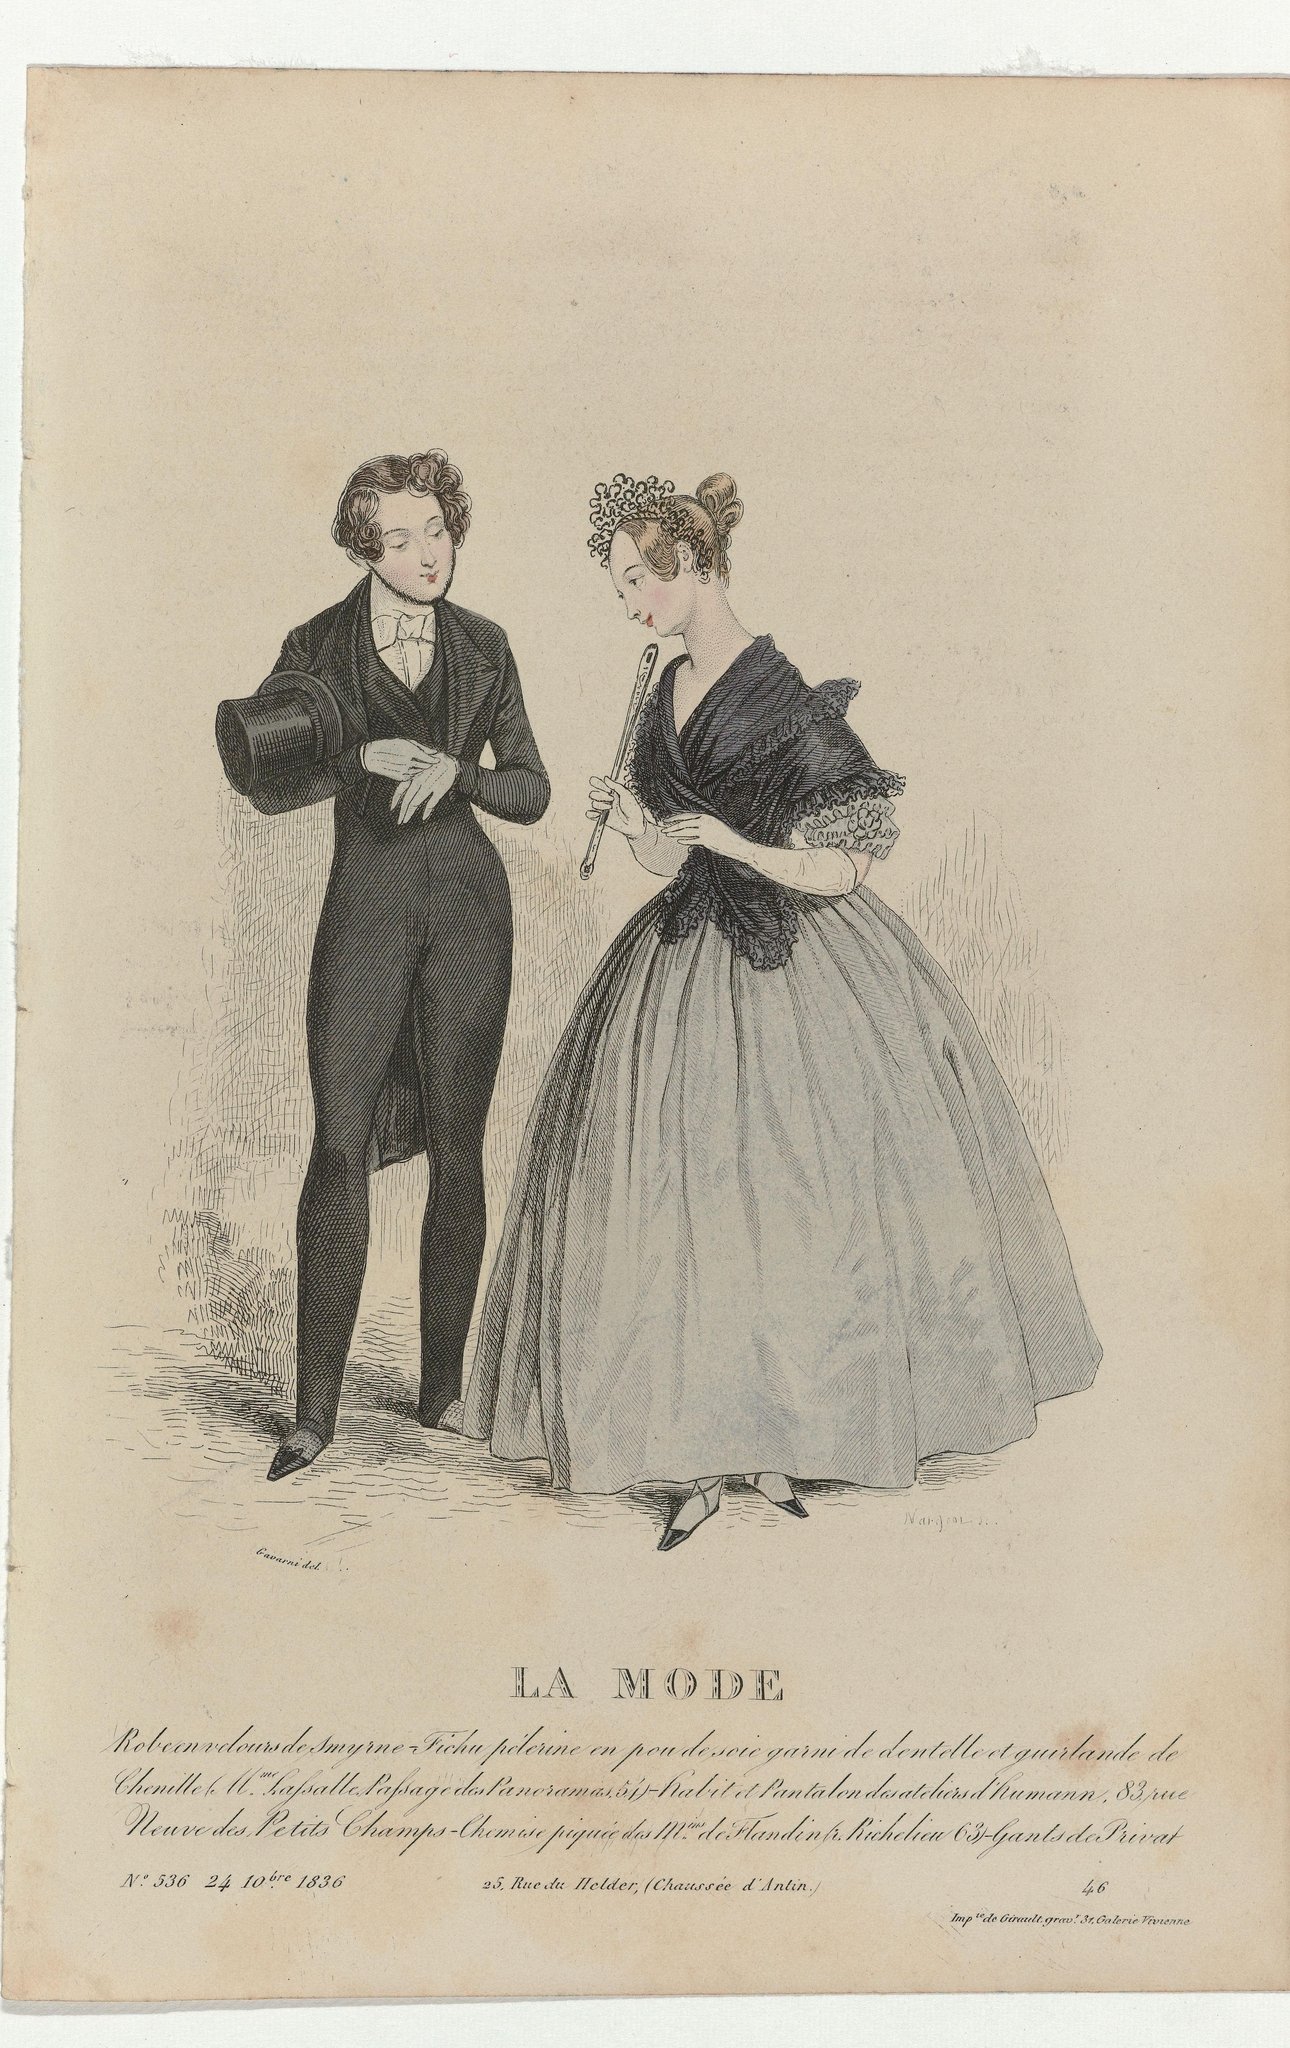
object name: fashion print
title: La Mode, 24 décembre 1836, Pl. 536 : Robe en velours de smyrne-Fichu (...)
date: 1836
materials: paper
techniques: engraving, etching, hand coloring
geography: paris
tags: clothing for the upper part of the body (vest) (+ men's clothes), dress, gown: evening dress (+ women's clothes), clothing for the upper part of the body (pelerine) (+ women's clothes), trousers, breeches, etc. (pantalon) (+ men's clothes), underclothes for the upper part of the body (shirt) (+ men's clothes), coat (+ men's clothes), ensembles of pieces of clothing (evening dress) (+ men's clothes), fashion plates, gloves, mittens, etc. (+ women's clothes), dress, gown (+ women's clothes), fan (+ women's clothes), piece of clothing covering the breast or décolleté (fichu) (+ women's clothes), gloves, mittens, etc. (+ men's clothes)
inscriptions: title: ‘La Mode.’, caption: ‘Robe en velours de smyrne-Fichu pélerine en pou de soie garni de dentelle et guirlande de Chenille ( M"me Lassalle, Passage des Panoramas, 54 )- habit et pantalon des ateliers d'Humann,83. rue Neuve des Petits Champs- Chemise piquée des M"ins de Flandin (r. Richelieu 63)- Gants de Privat’, address: ‘25, Rue du Helder, ( Chaussée d'Antin )’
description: Een paar in avondkleding. Volgens het onderschrift: japon van 'velours de smyrne'. 'Fichu pelerine' van 'pou de soie', afgezet met kant en guirlande van chenille van Lassalle. 'Habit' en spanbroek uit de ateliers van Humann. 'Chemise piquée' uit de winkels van Flandin. Handschoenen van Privat. Prent uit het modetijdschrift La Mode (1829-1855).